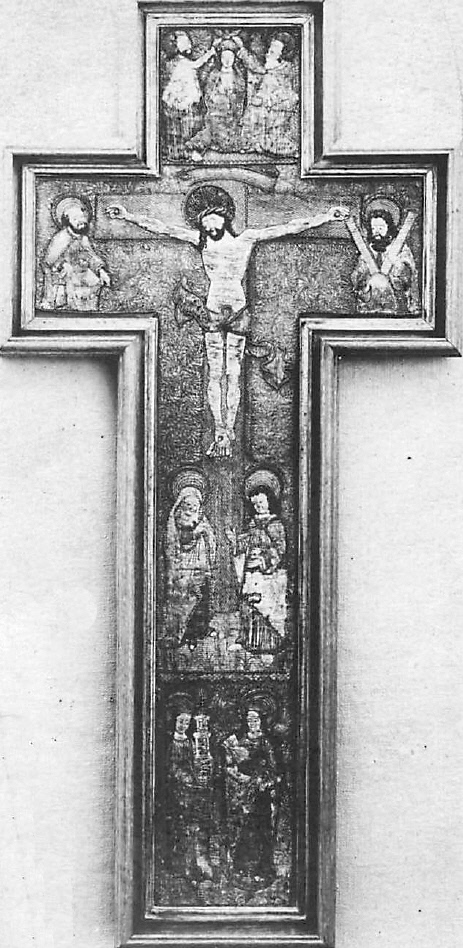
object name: orphrey, cross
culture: french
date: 1401-1500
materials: gold thread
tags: christ,saints